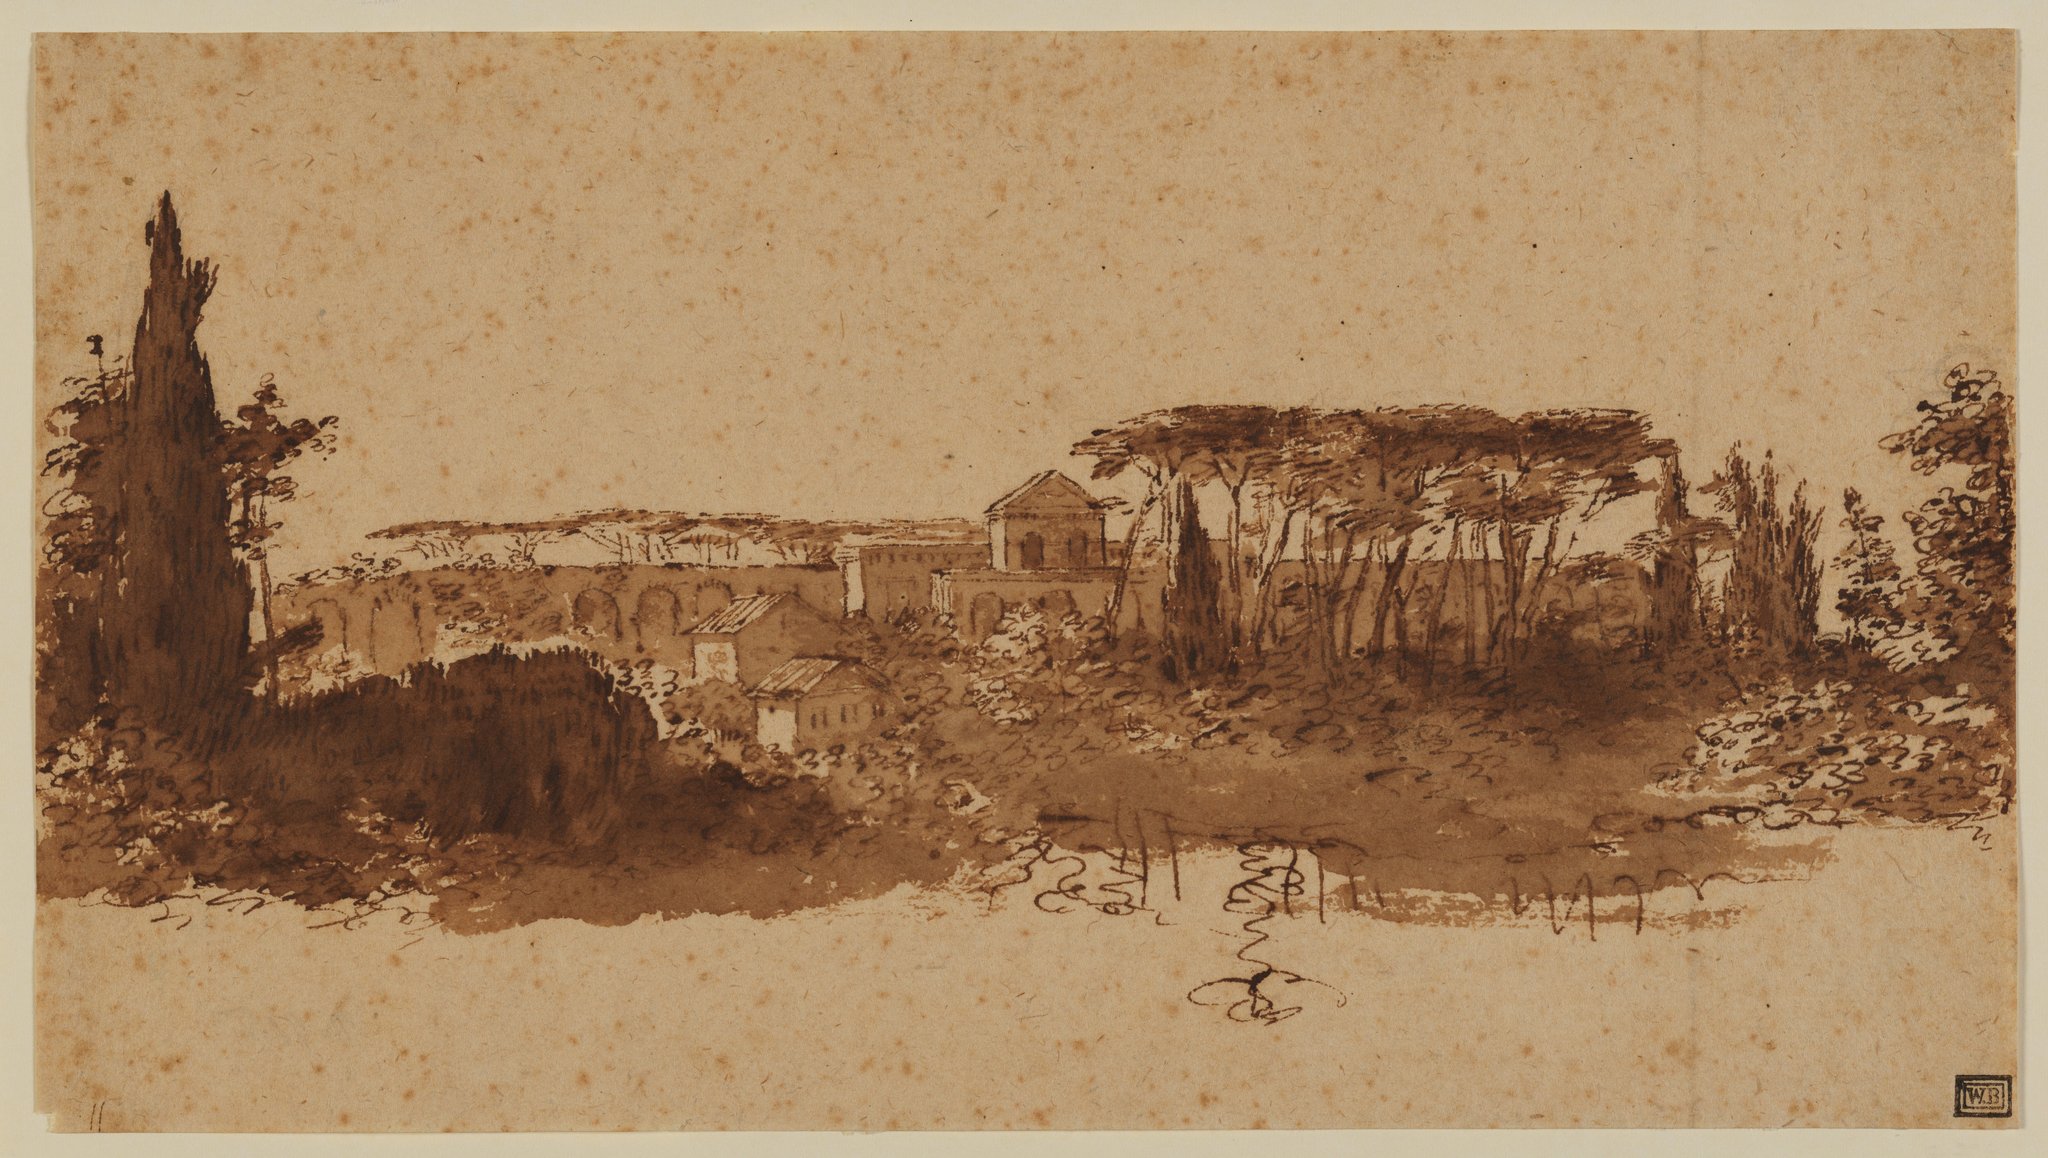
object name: drawing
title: Roman Landscape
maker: claude lorrain (claude gellée)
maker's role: artist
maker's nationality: french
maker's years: 1604-1682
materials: ink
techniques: wash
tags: landscapes